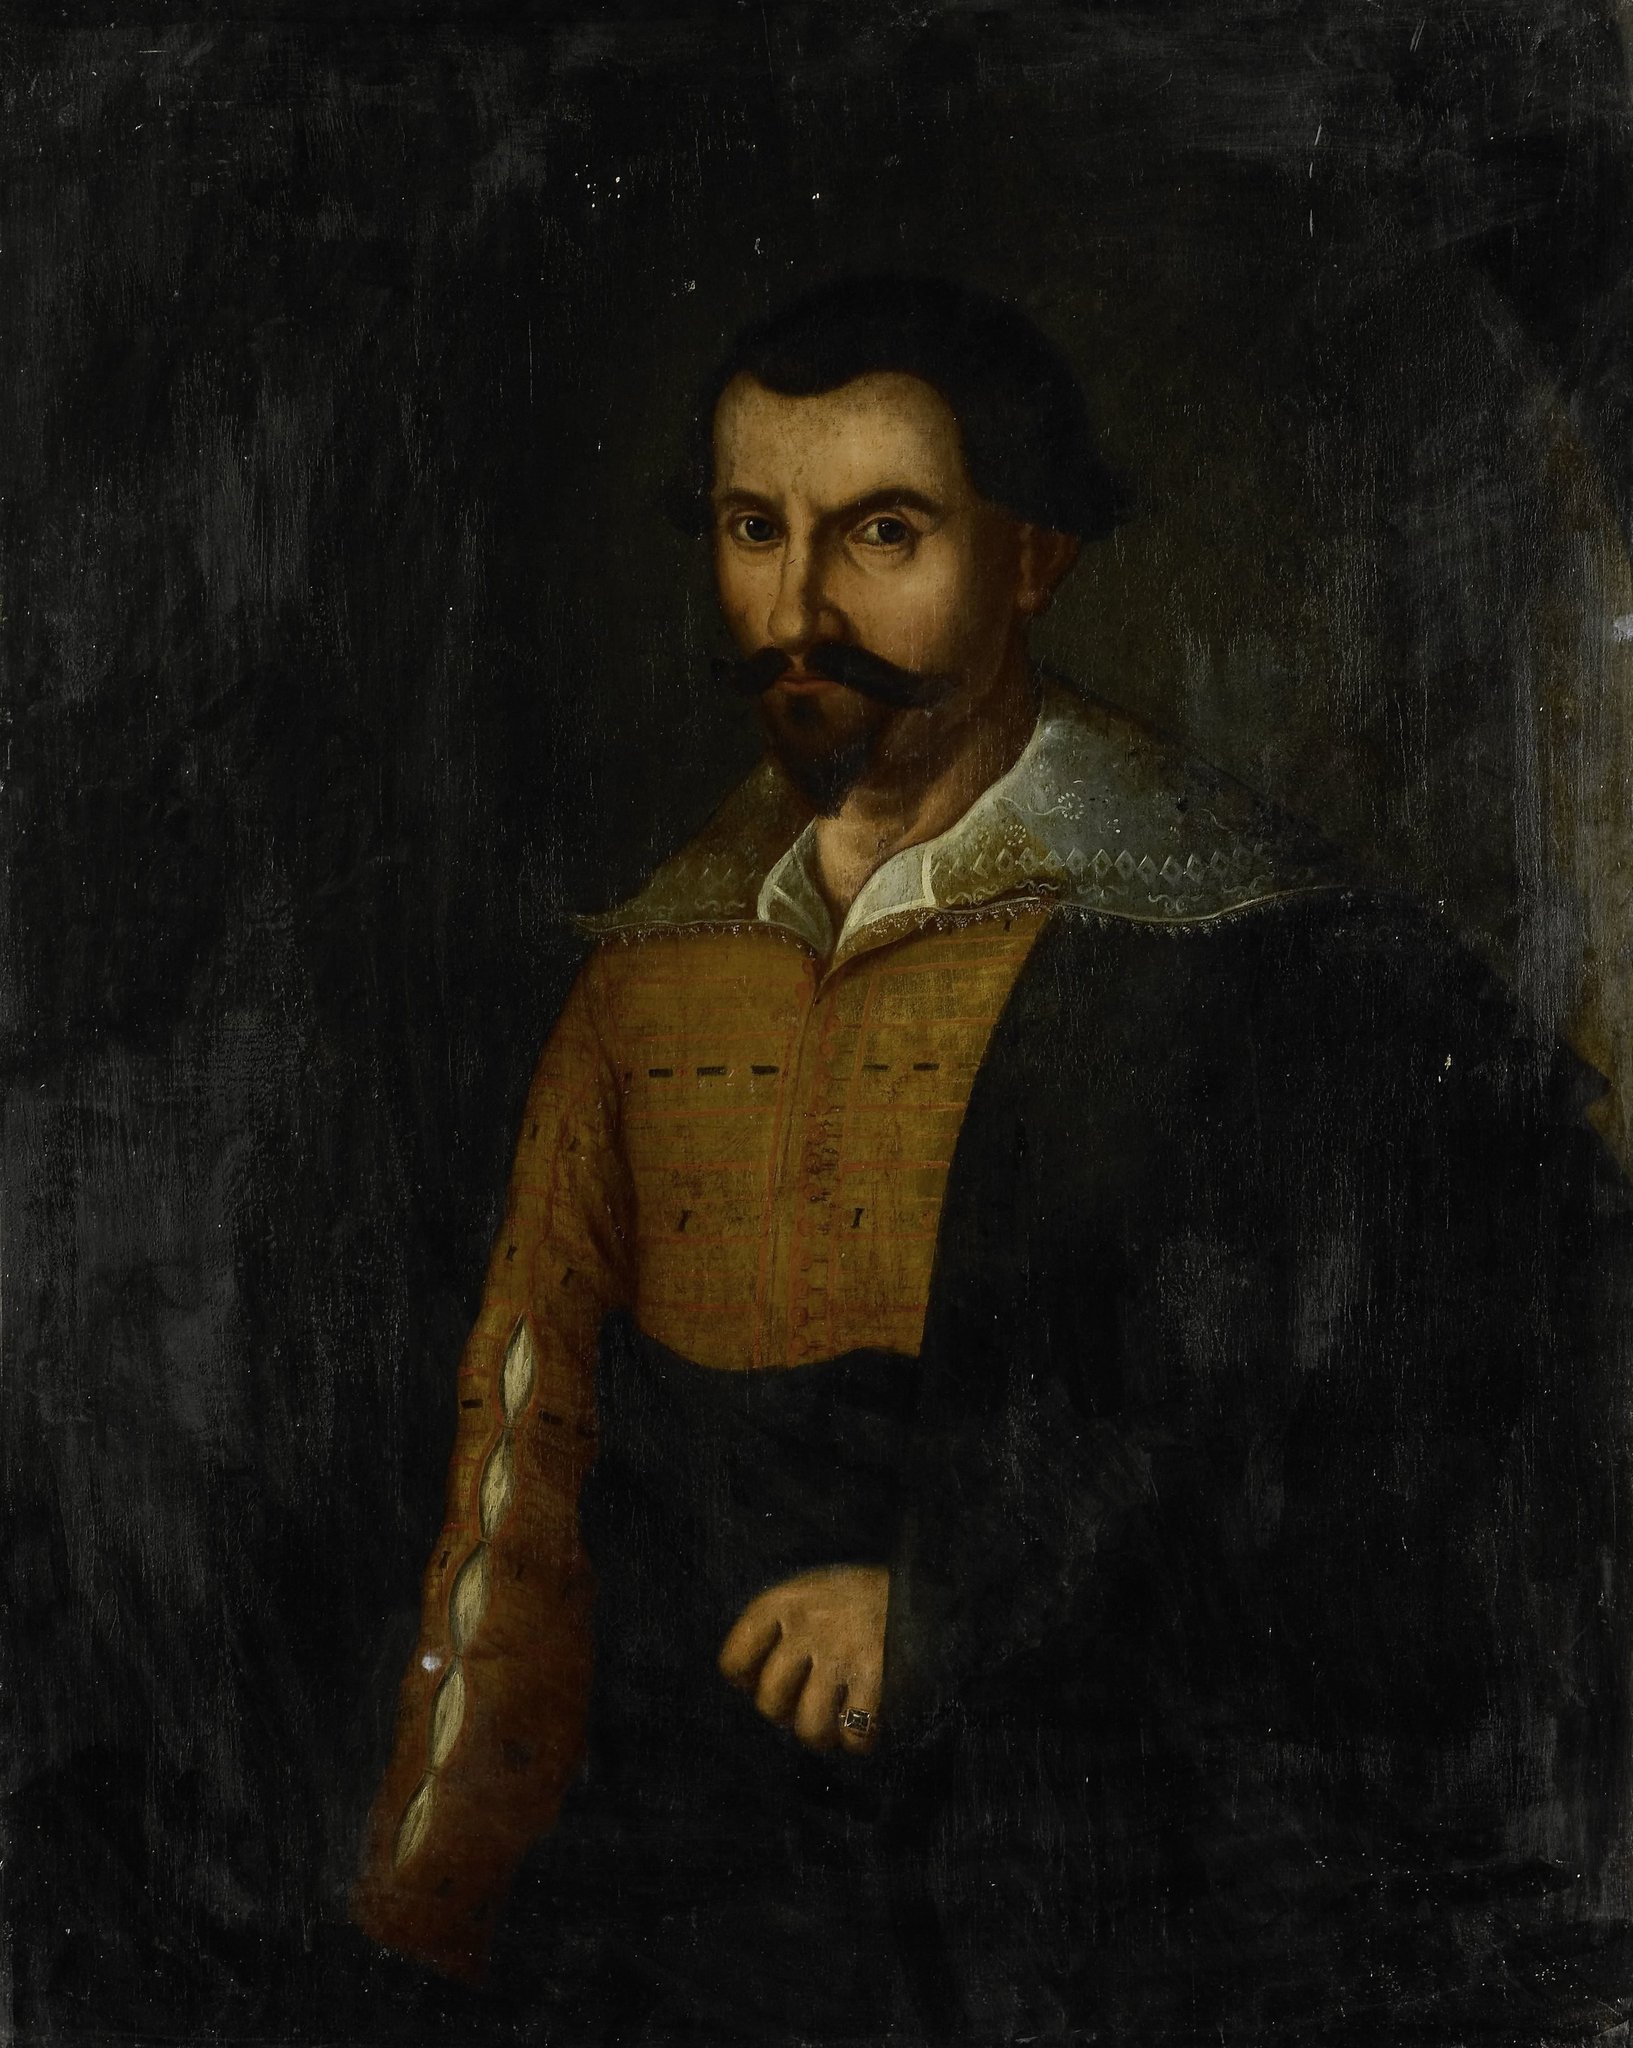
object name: painting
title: Portrait of Pieter de Carpentier, Governor-General of the Dutch East Indies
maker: Anonymous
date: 1623-1675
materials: oil, panel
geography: netherlands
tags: antwerp, amsterdam, colonial governor, historical persons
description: Portret van Pieter de Carpentier (1588-1659). Gouverneur-generaal (1623-1627). Staand, ten halven lijve, naar links. Onderdeel van een reeks van portretten van de gouverneurs-generaal van het voormalige Nederlands Oost-Indië.